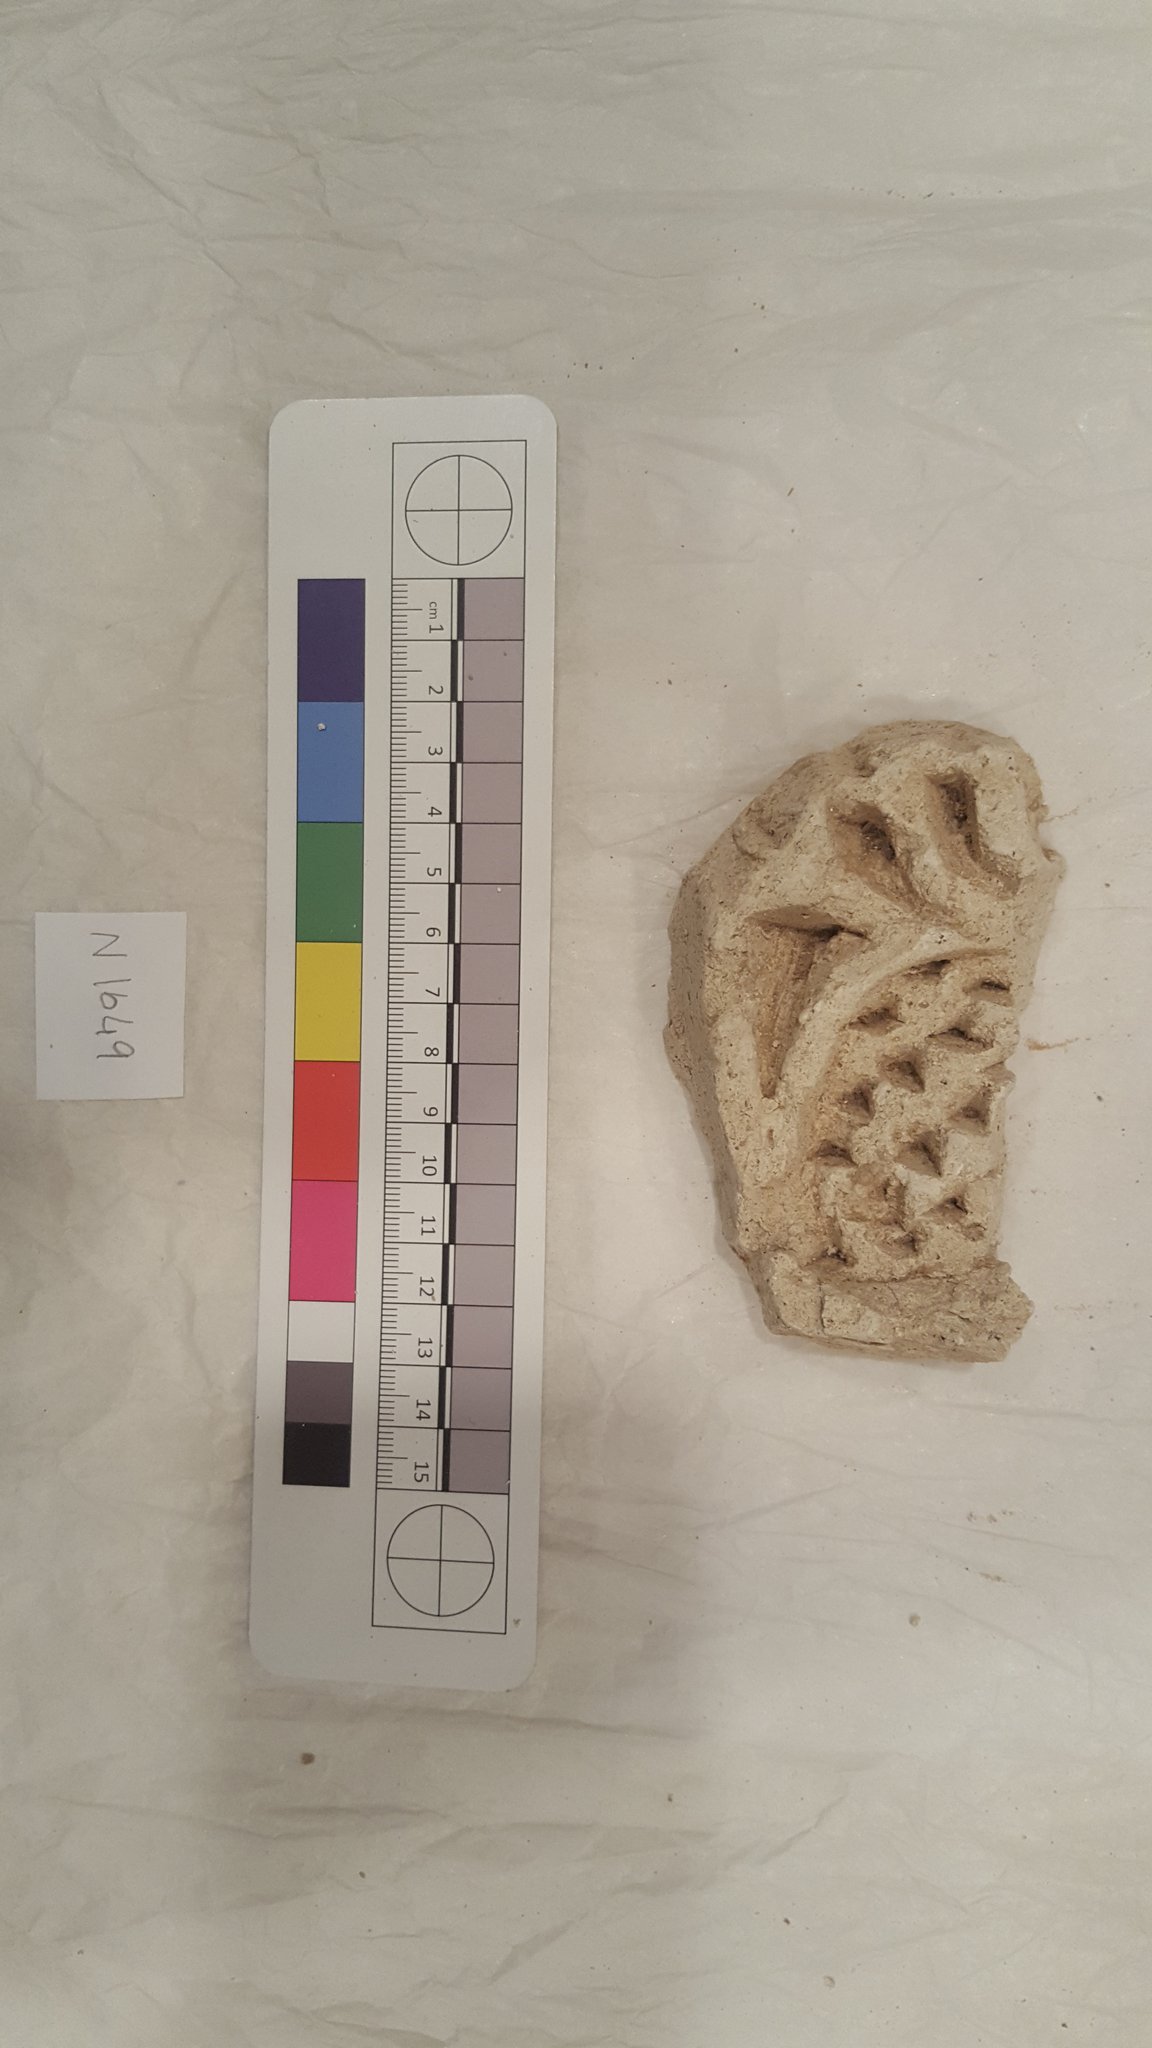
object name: fragment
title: Stucco Fragment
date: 701-1200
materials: plaster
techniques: carving, painting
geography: iran